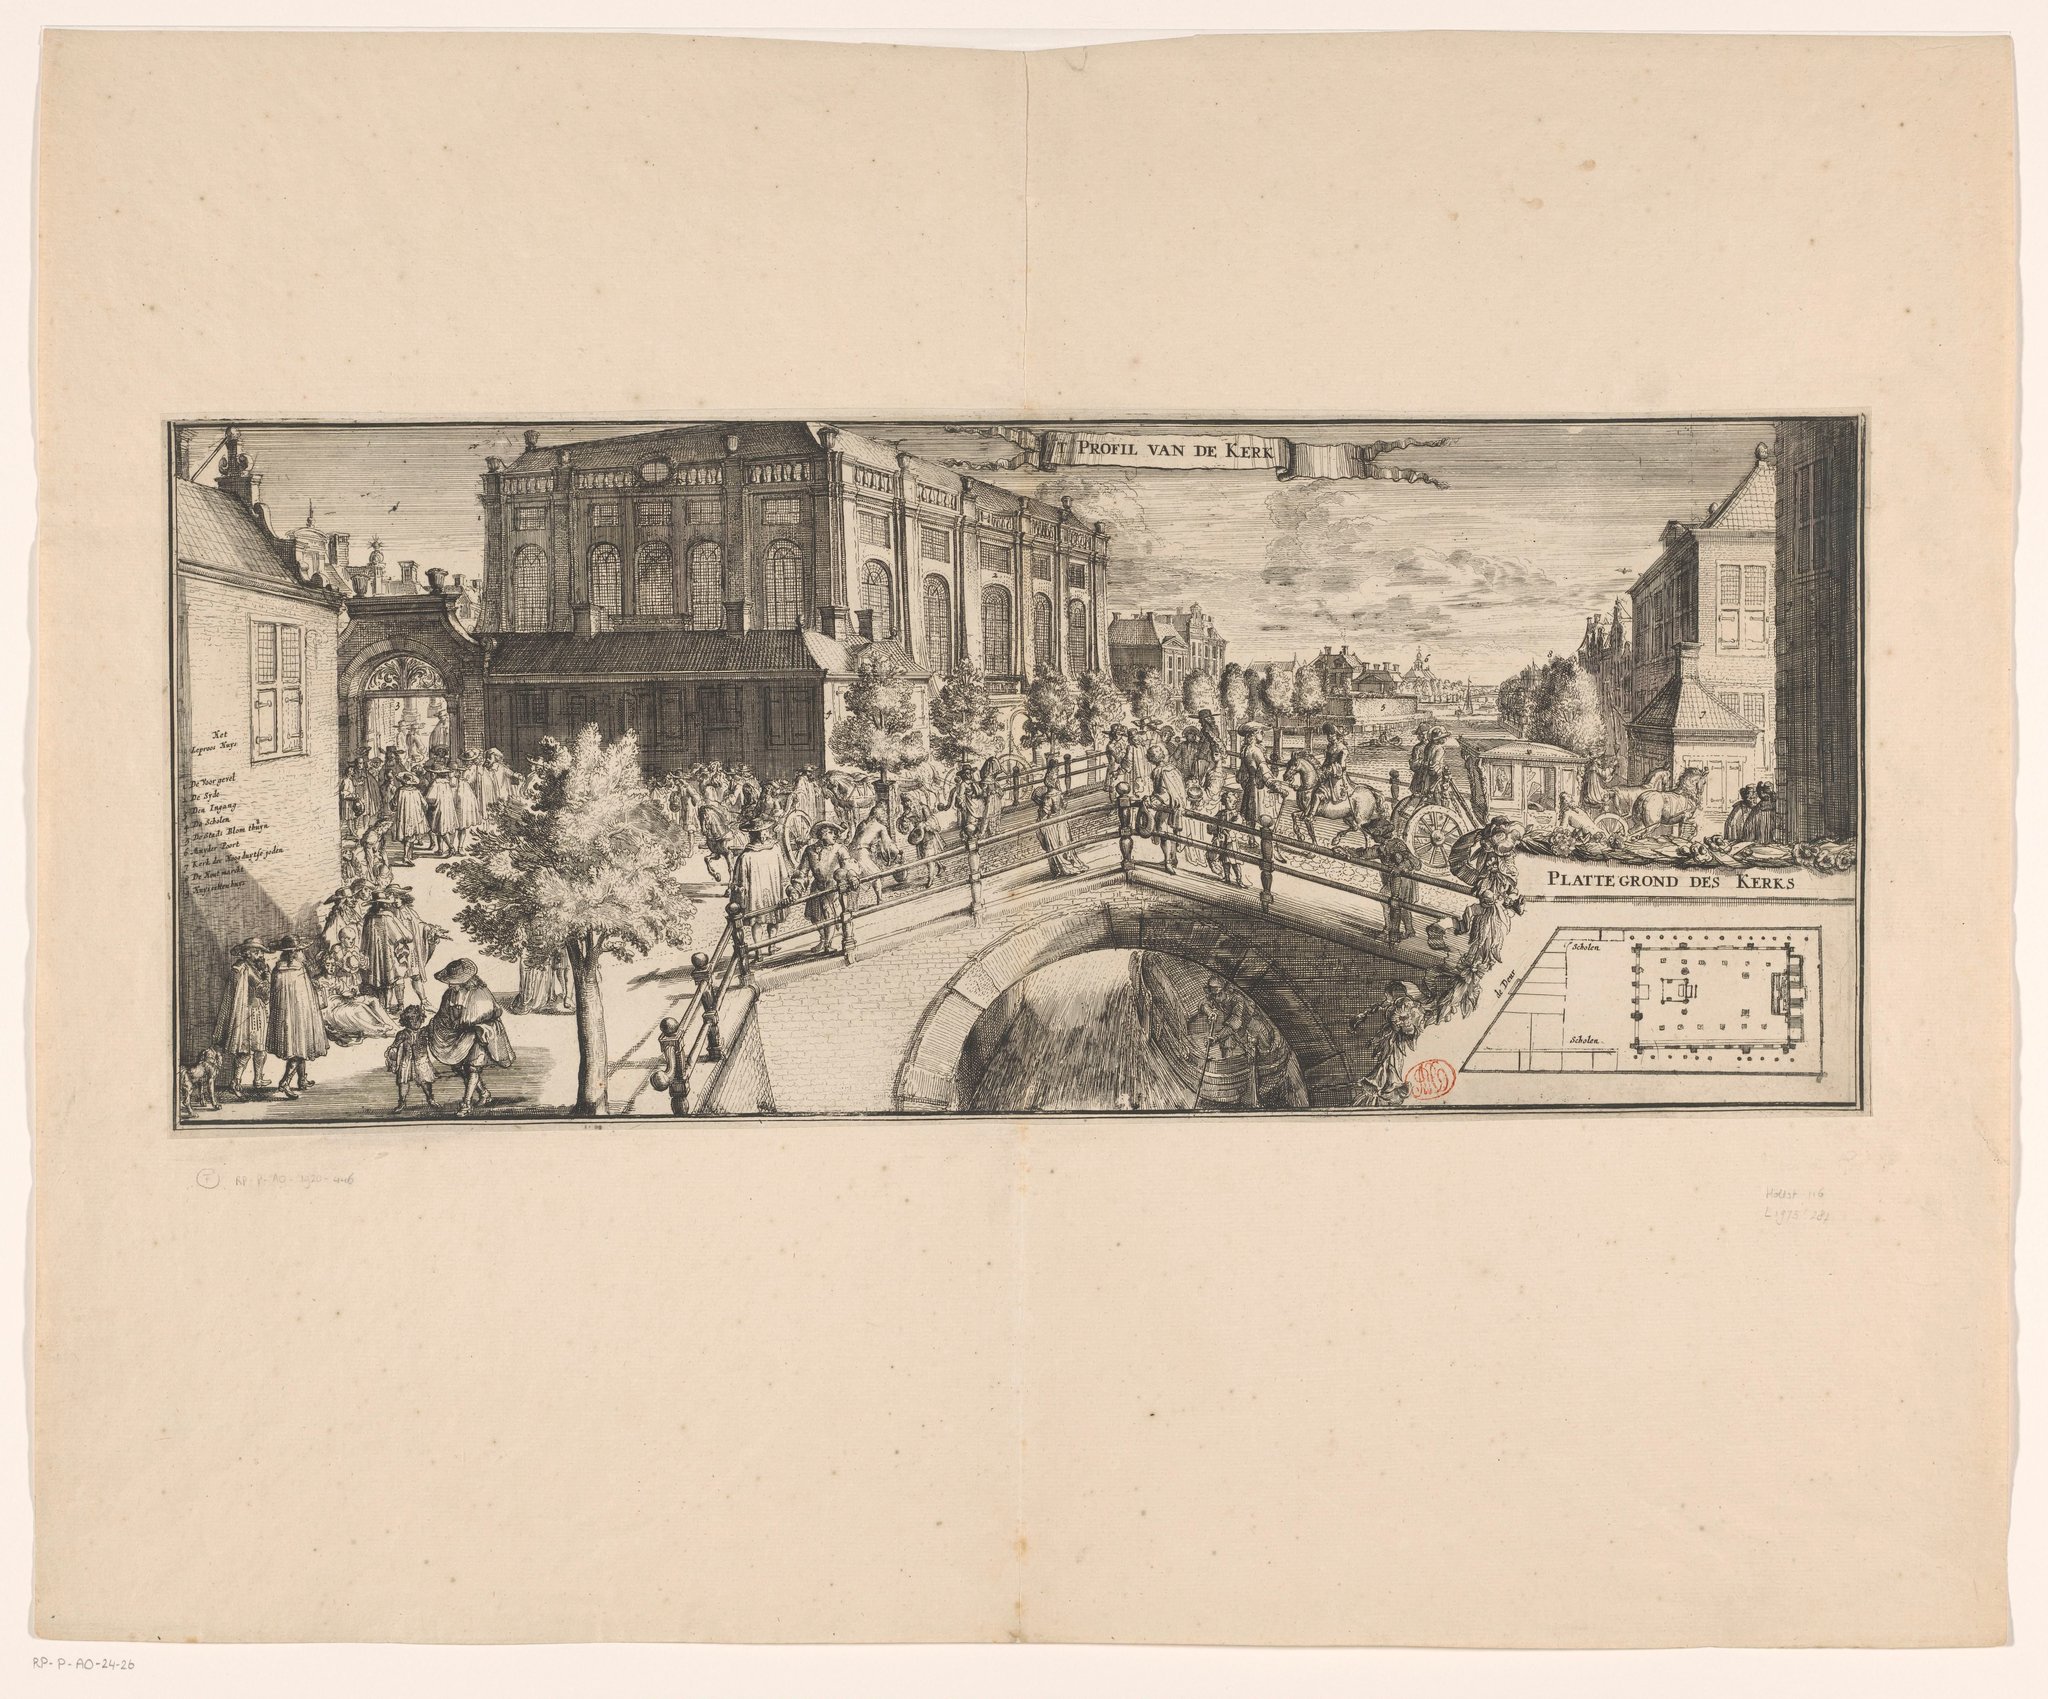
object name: print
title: T Profil van de Kerk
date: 1695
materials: paper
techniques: engraving, etching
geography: amsterdam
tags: bridge in city across river, canal, etc. (+ city(-scape) with figures, staffage), 'sephardim' ~ jewish communities, the synagogue (as building and place of worship ~ jewish religion), plan ~ architecture, street (+ city(-scape) with figures, staffage)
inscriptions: collector's mark: Lugt 195, collector's mark: Lugt 2233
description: Gezicht op de Portugese Synagoge (links van het midden) te Amsterdam, rond 1695. Links op de voorgrond een deel van het Leprozenhuis met de legenda 1-9. Rechts een deel van een van de gebouwen die dienden als synagoge voor de Hoogduitse gemeente. Op straat en op de brug vele figuren en een koets. Rechtsonder een plattegrond van de het gebouw. Boven rechts van het midden een banderol met de titel.